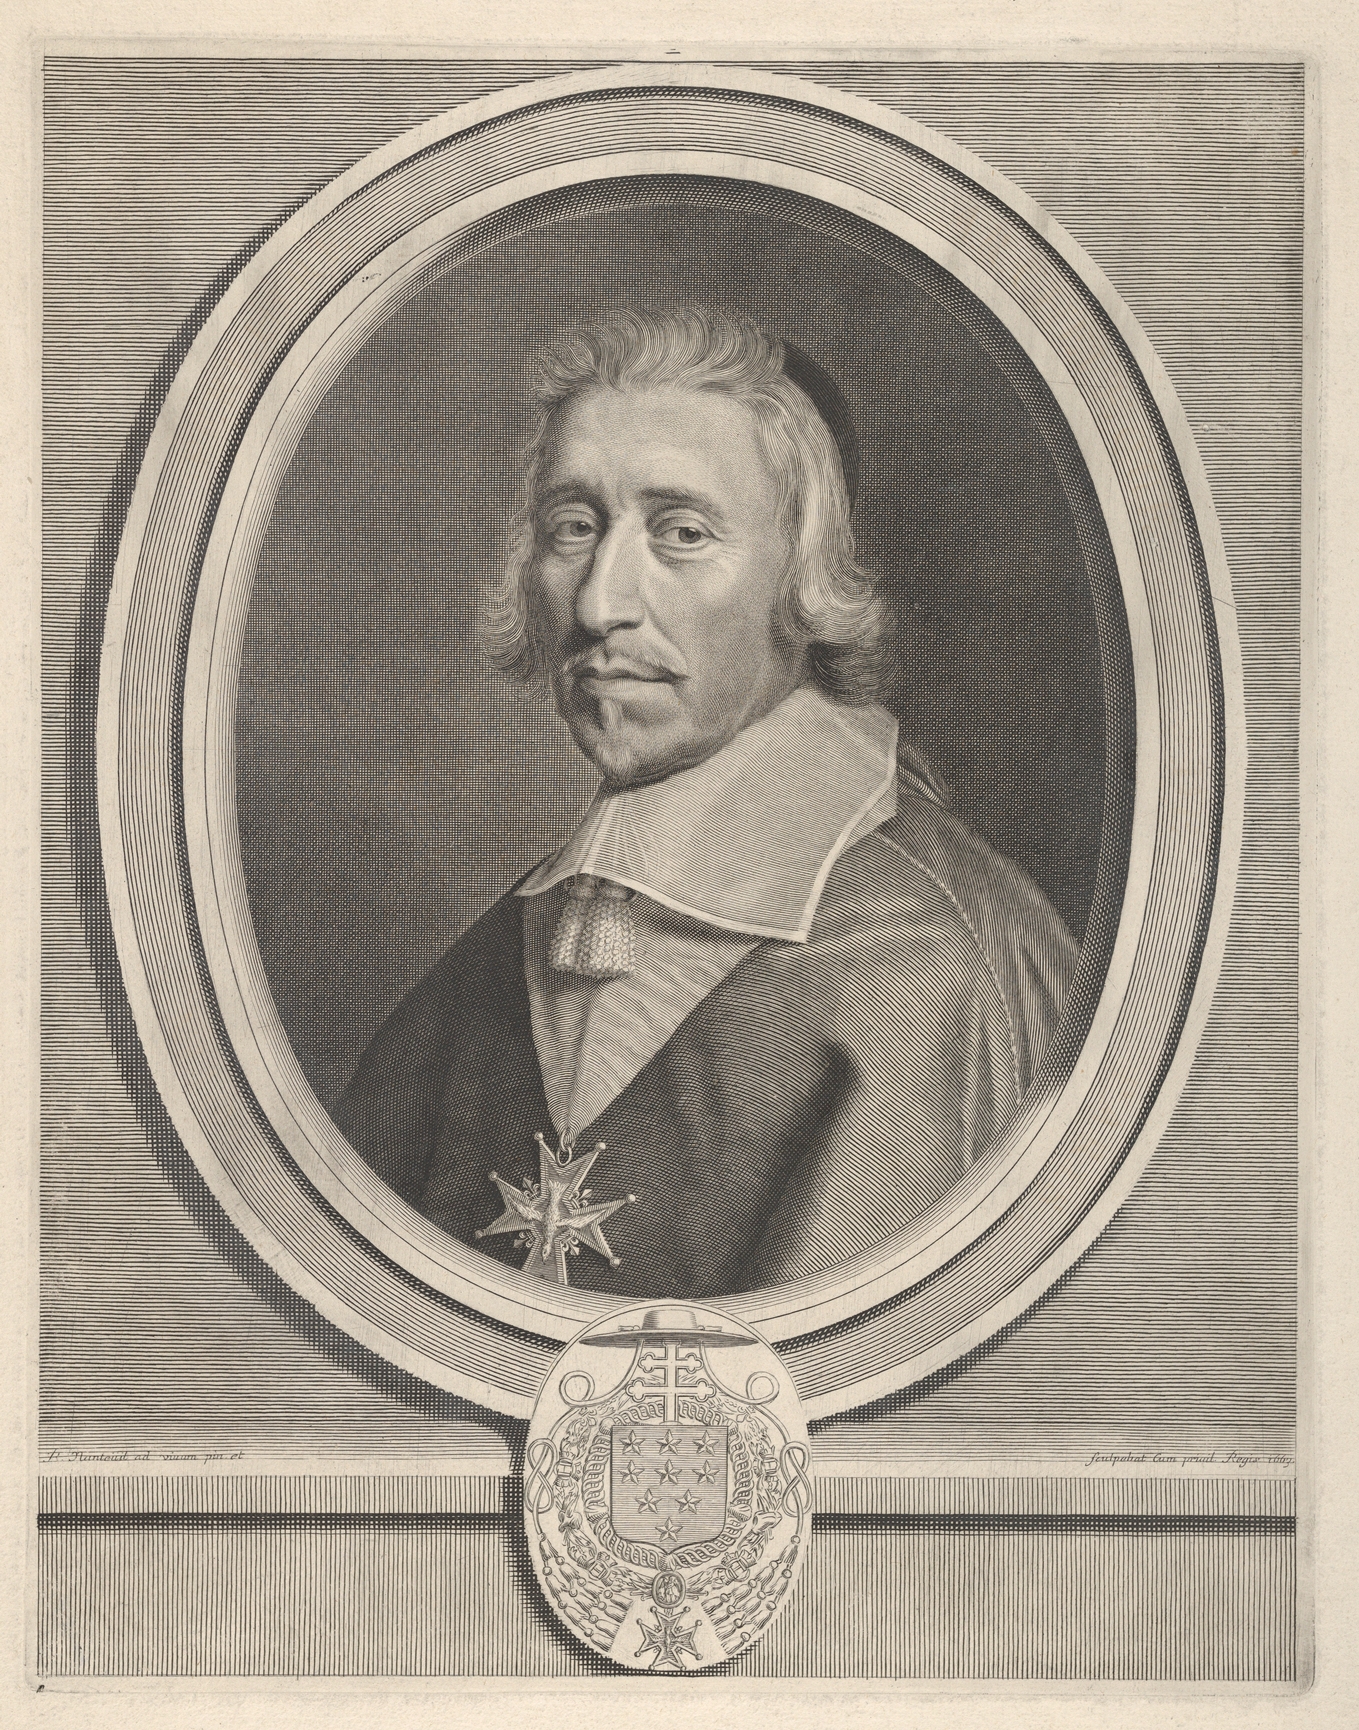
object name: print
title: Hardouin de Beaumont de Péréfixe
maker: robert nanteuil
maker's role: artist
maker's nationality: french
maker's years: 1623-1678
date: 1663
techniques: engraving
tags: men,portraits,coat of arms